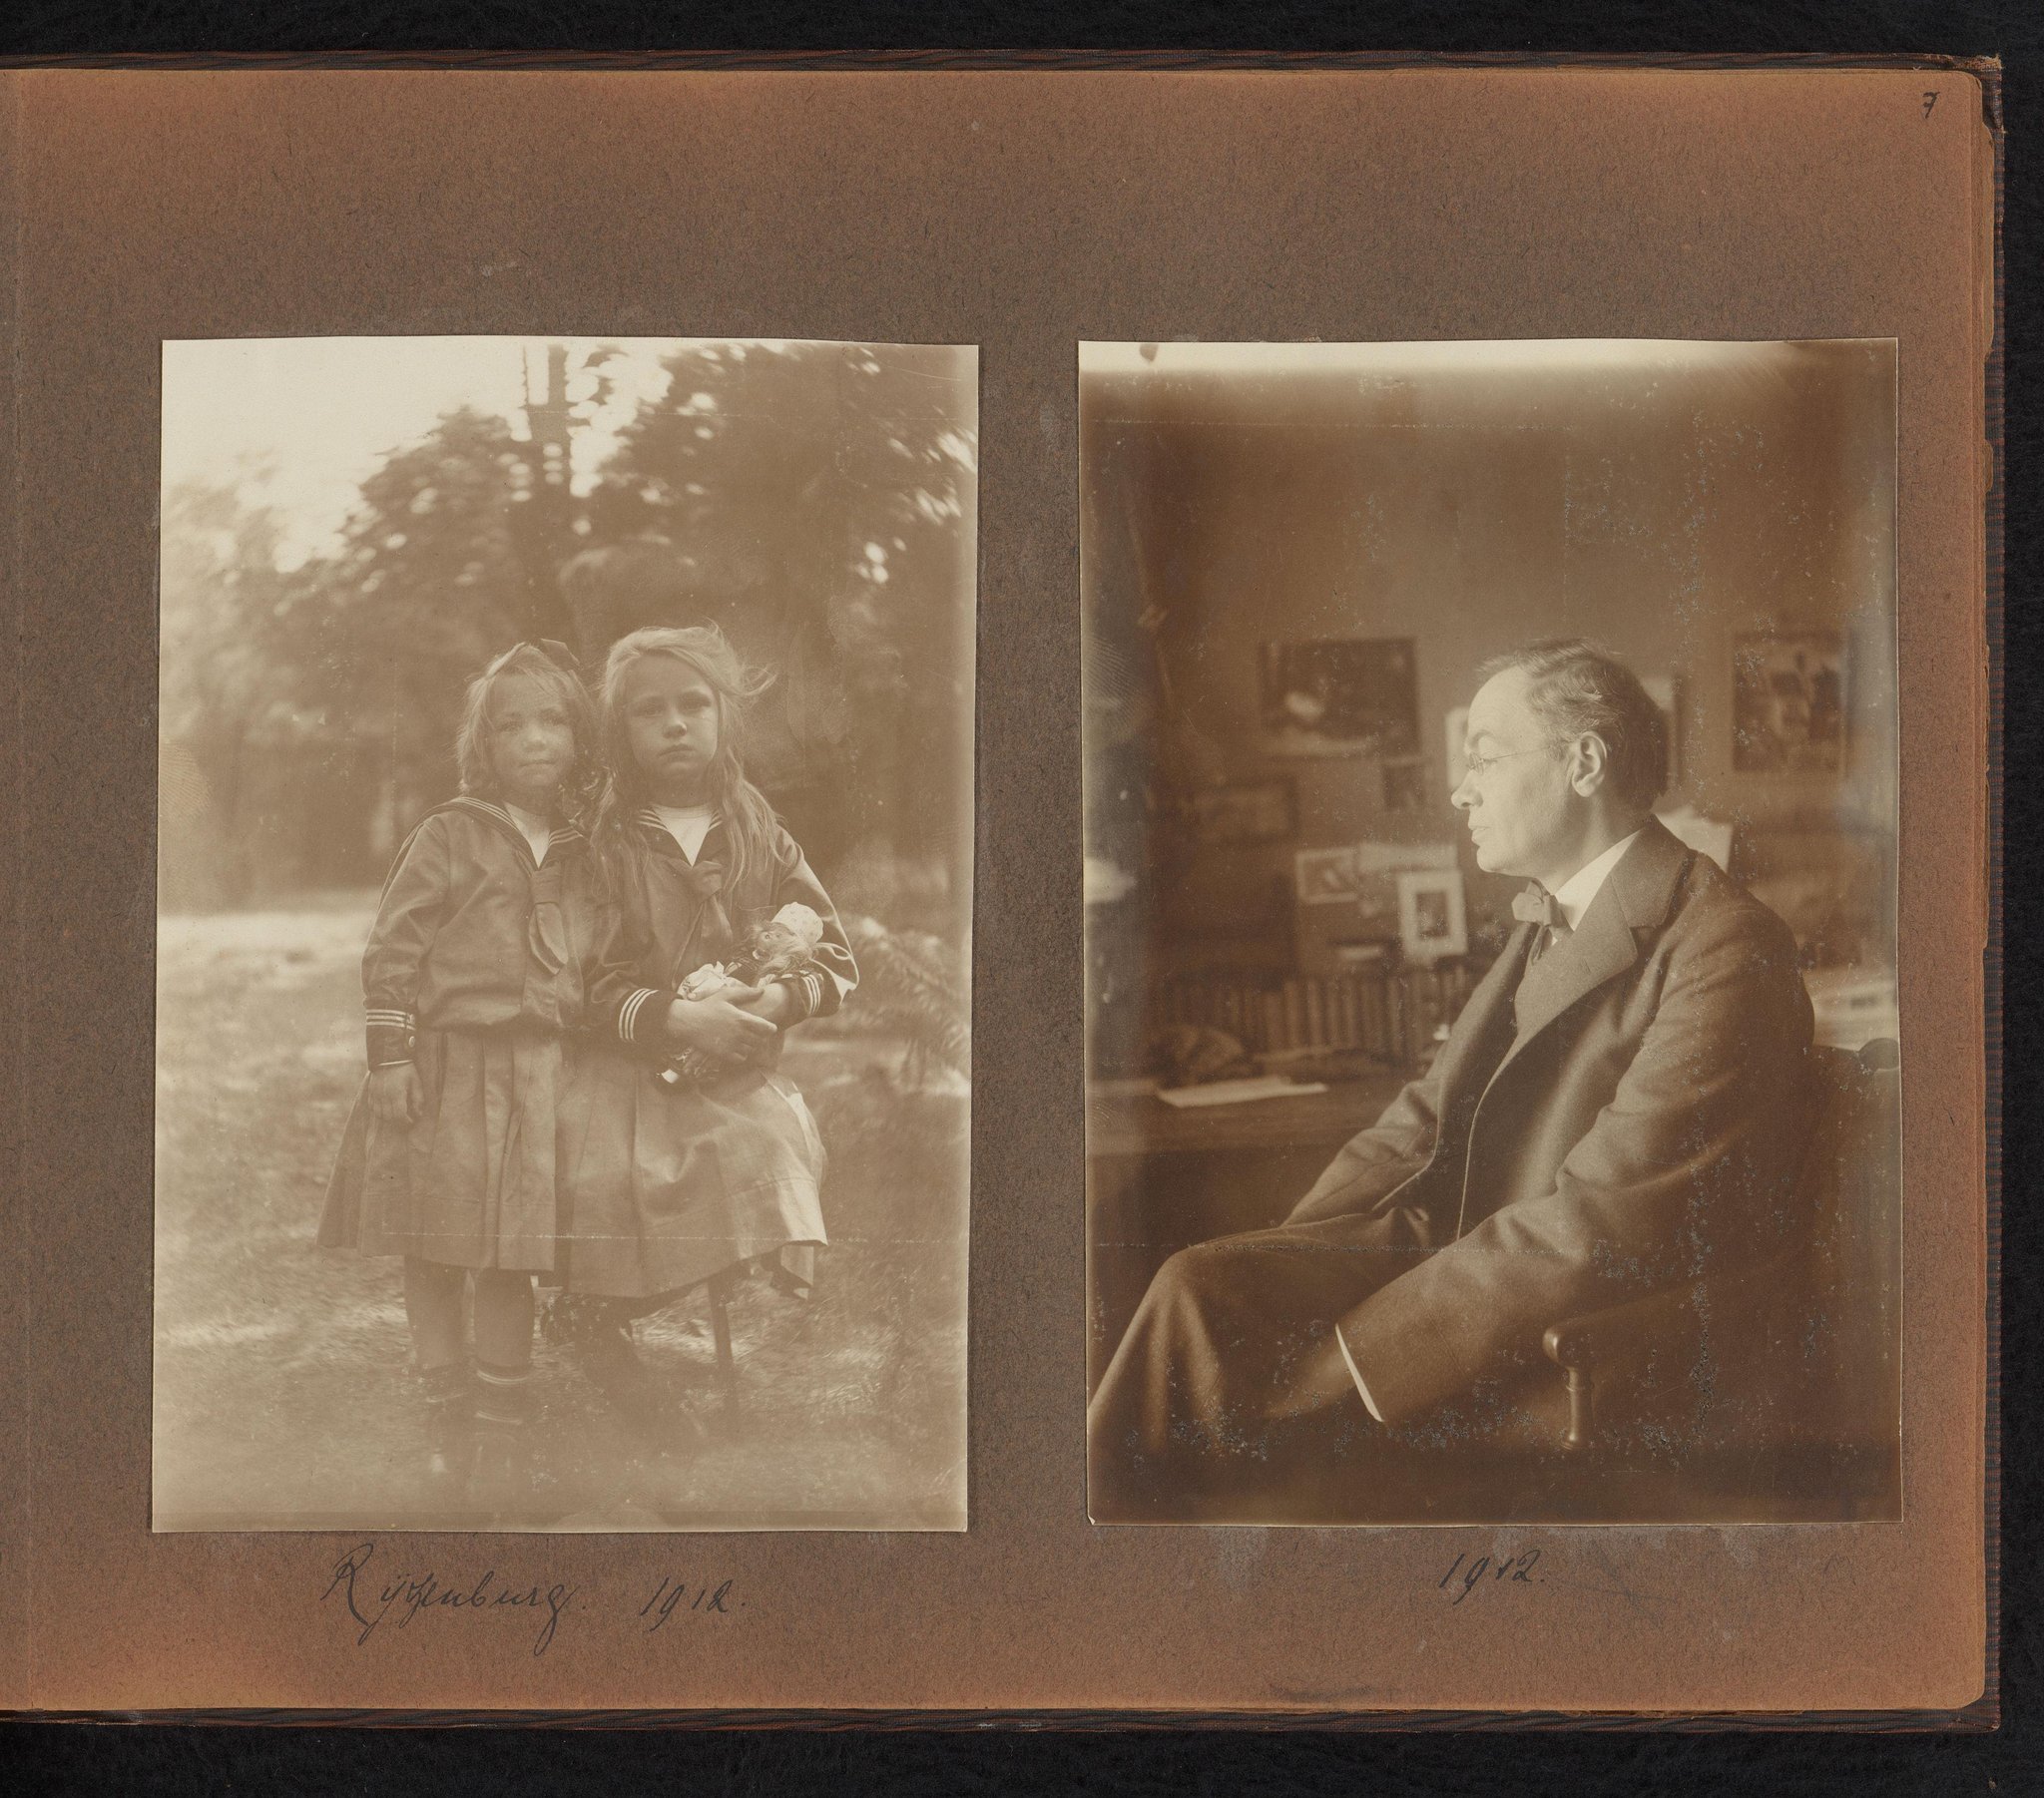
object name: album leaf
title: Bladzijde uit het fotoalbum van de familie Diepenbrock met 2 foto 's van Thea en Joanna Diepenbrock in veld en van Alphons Diepenbrock in interieur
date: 1912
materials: cardboard, photographic support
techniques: photography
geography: amsterdam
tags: amsterdam, alphons diepenbrock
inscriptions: inscription: ‘Rijzenburg (?) 1912. 1912.’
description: Bruin albumblad 7 van familiealbum van Alphons Diepenbrock.